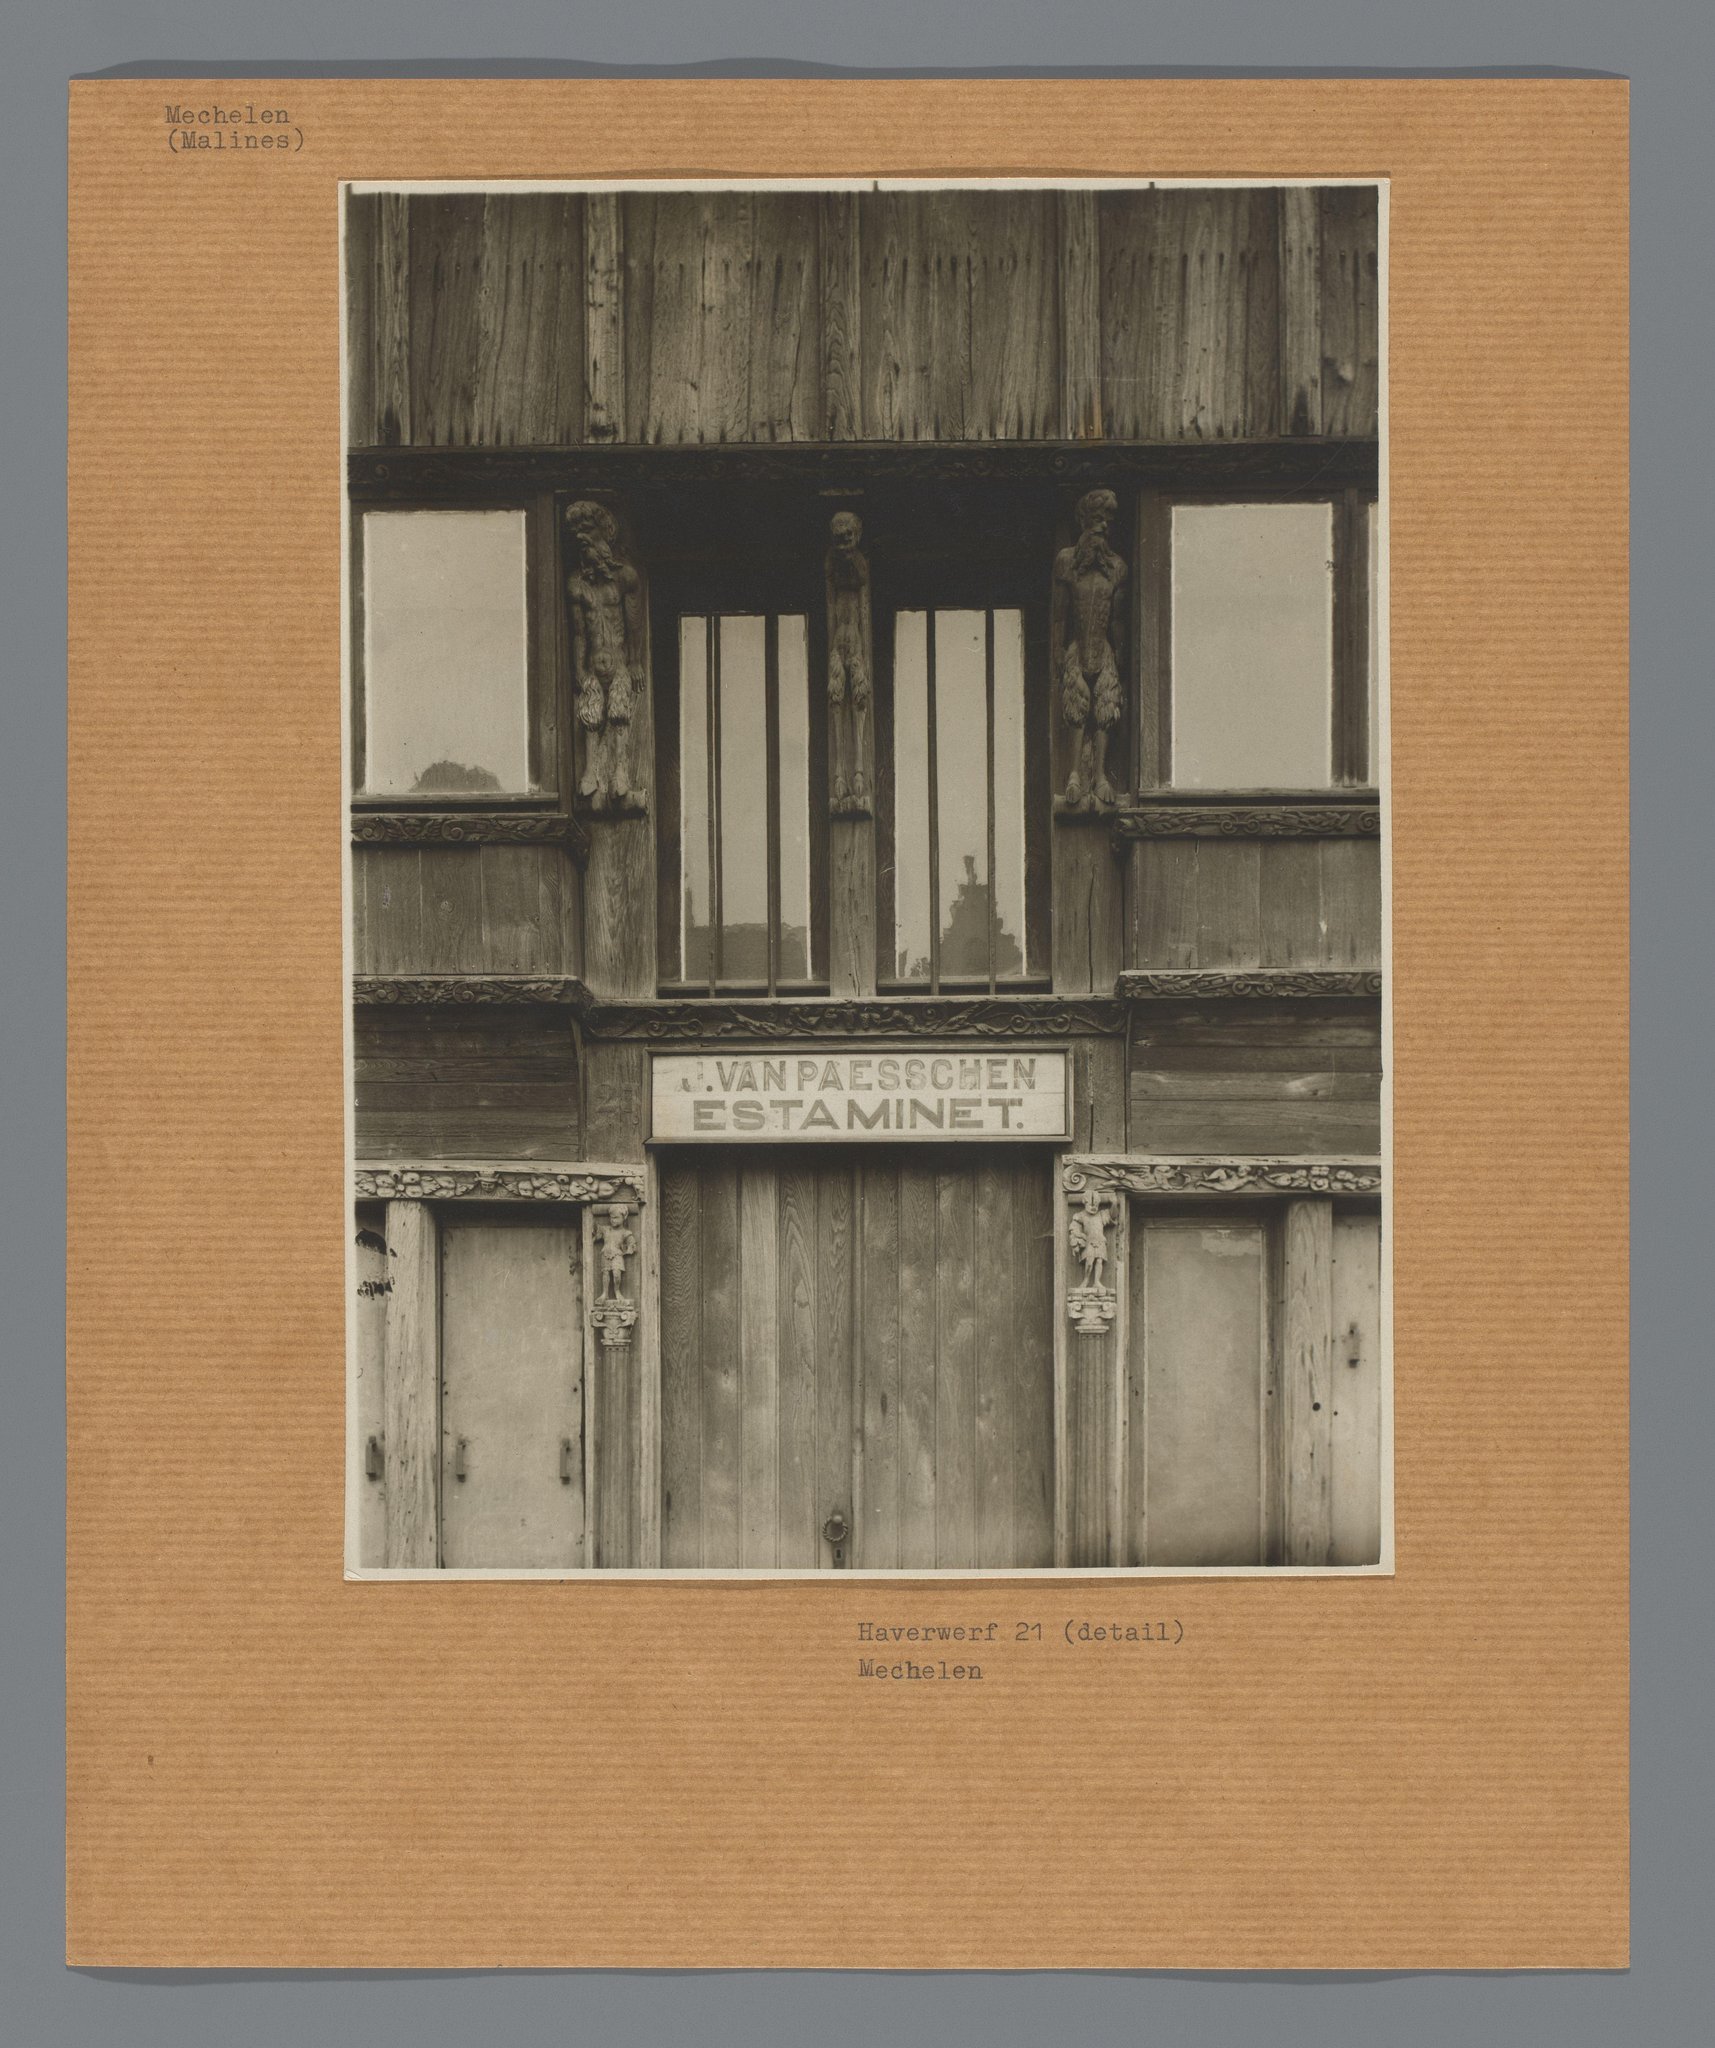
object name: photograph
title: Mechelen. Haverwerf 21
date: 1880-1930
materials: photographic support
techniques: gelatin silver print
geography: darmstadt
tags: mechelen